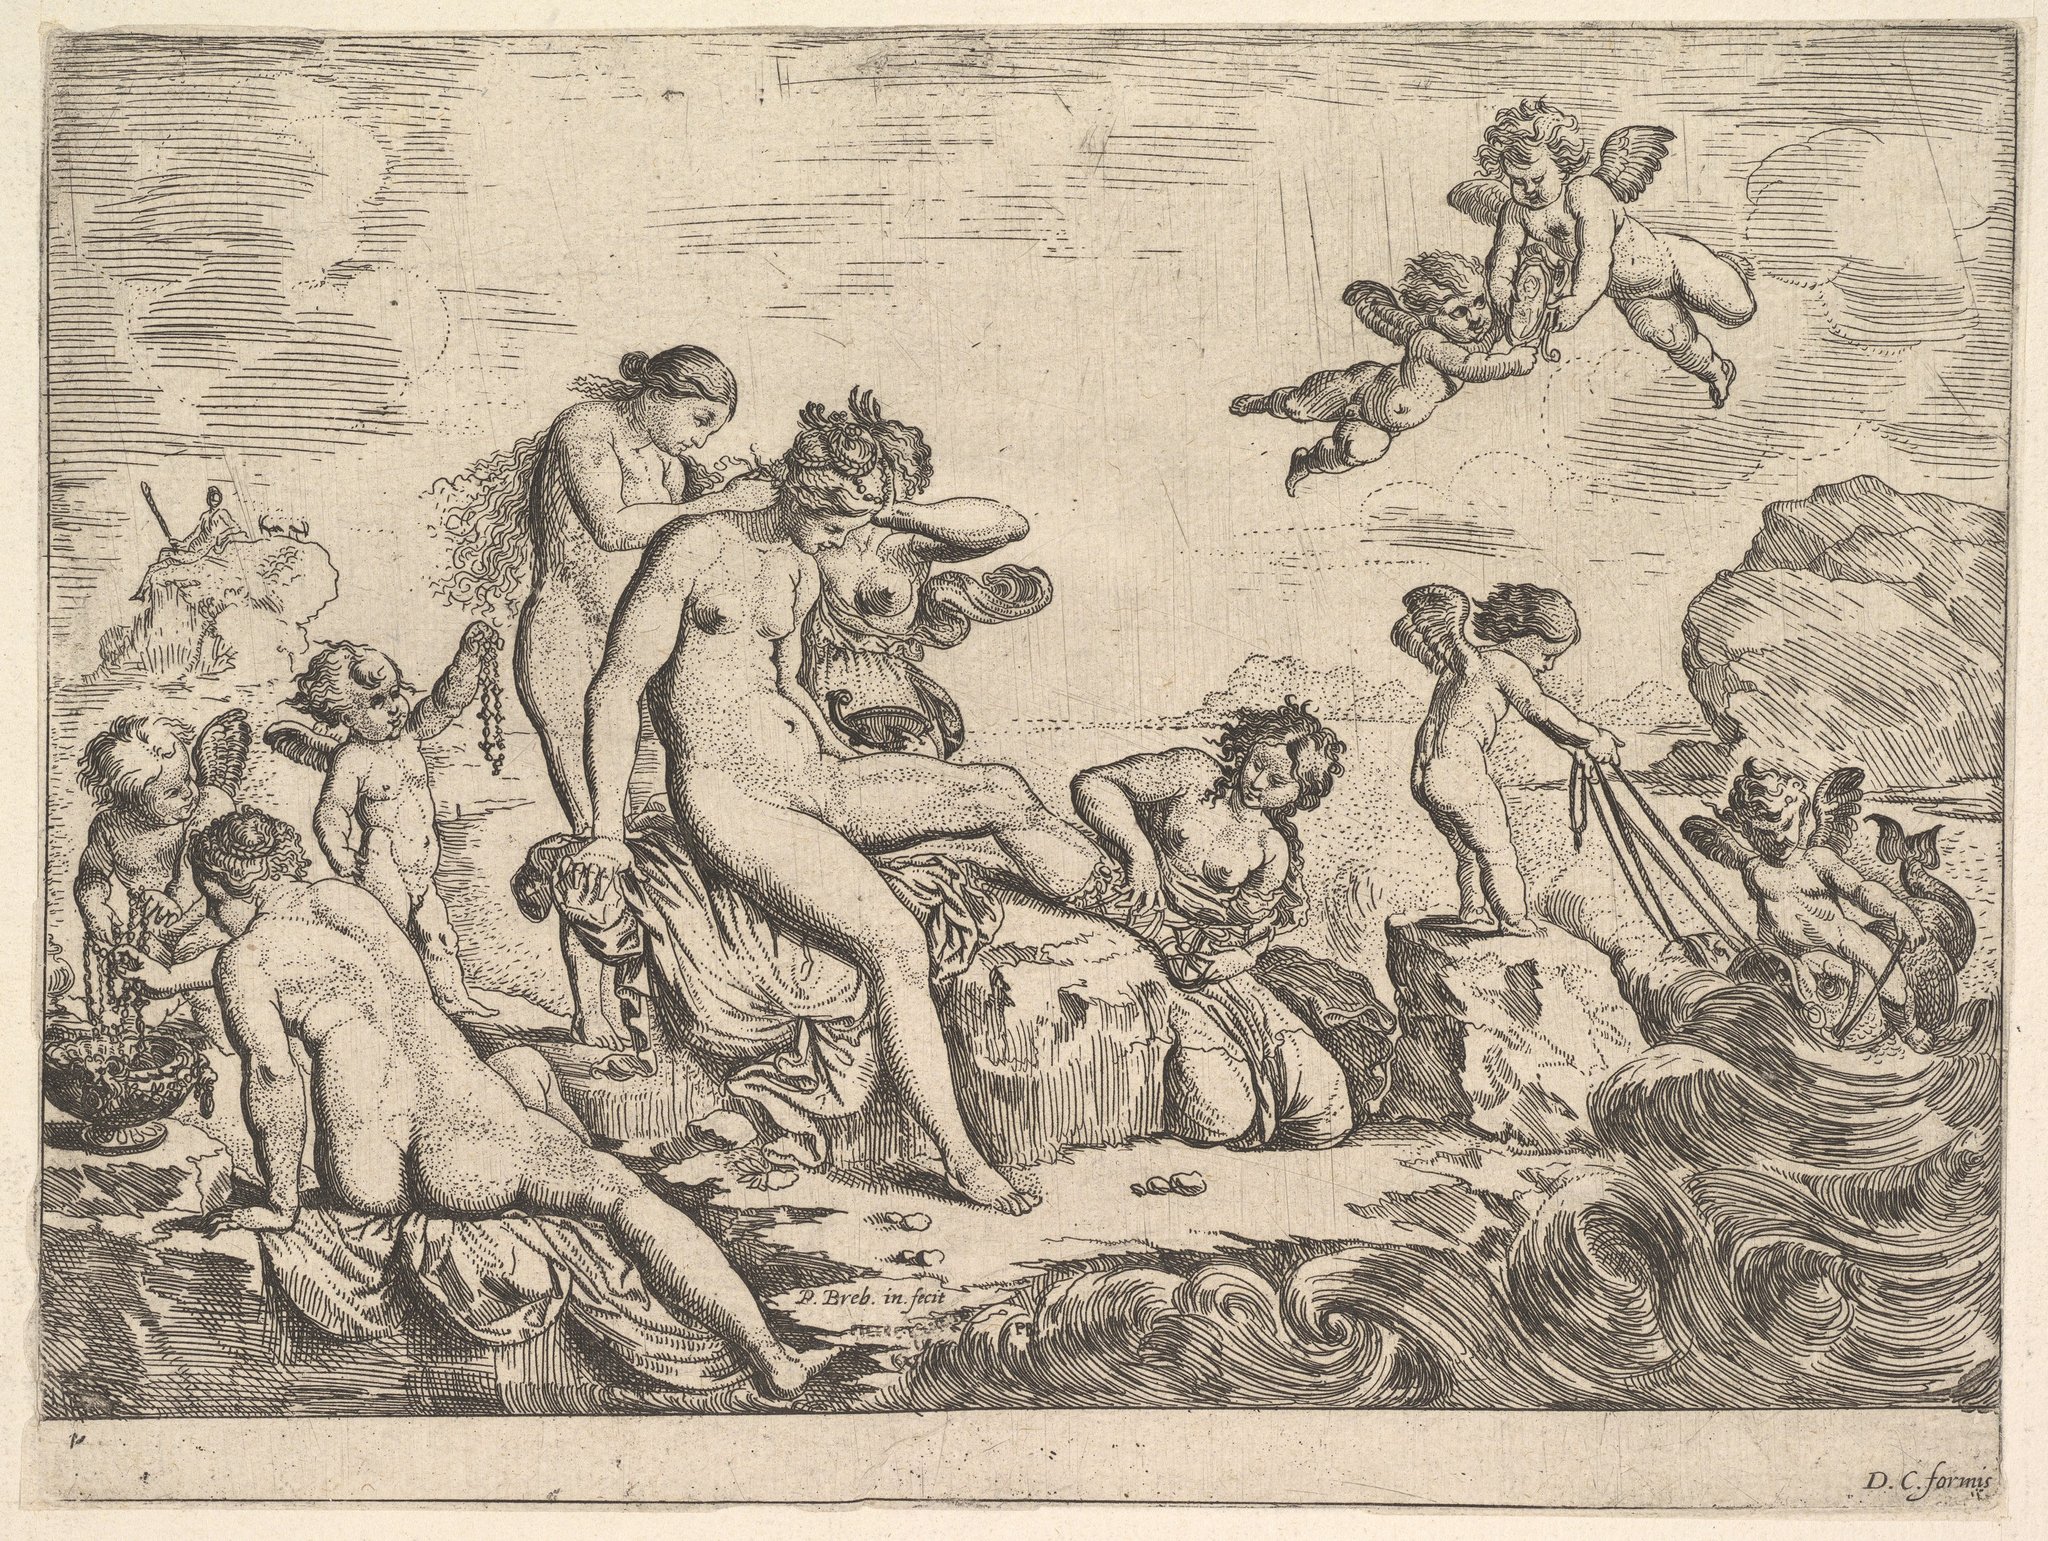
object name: print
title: Toilet of Thetis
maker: pierre brebiette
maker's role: artist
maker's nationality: french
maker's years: 1598-1642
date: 1610-1642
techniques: etching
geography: france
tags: female nudes,putti